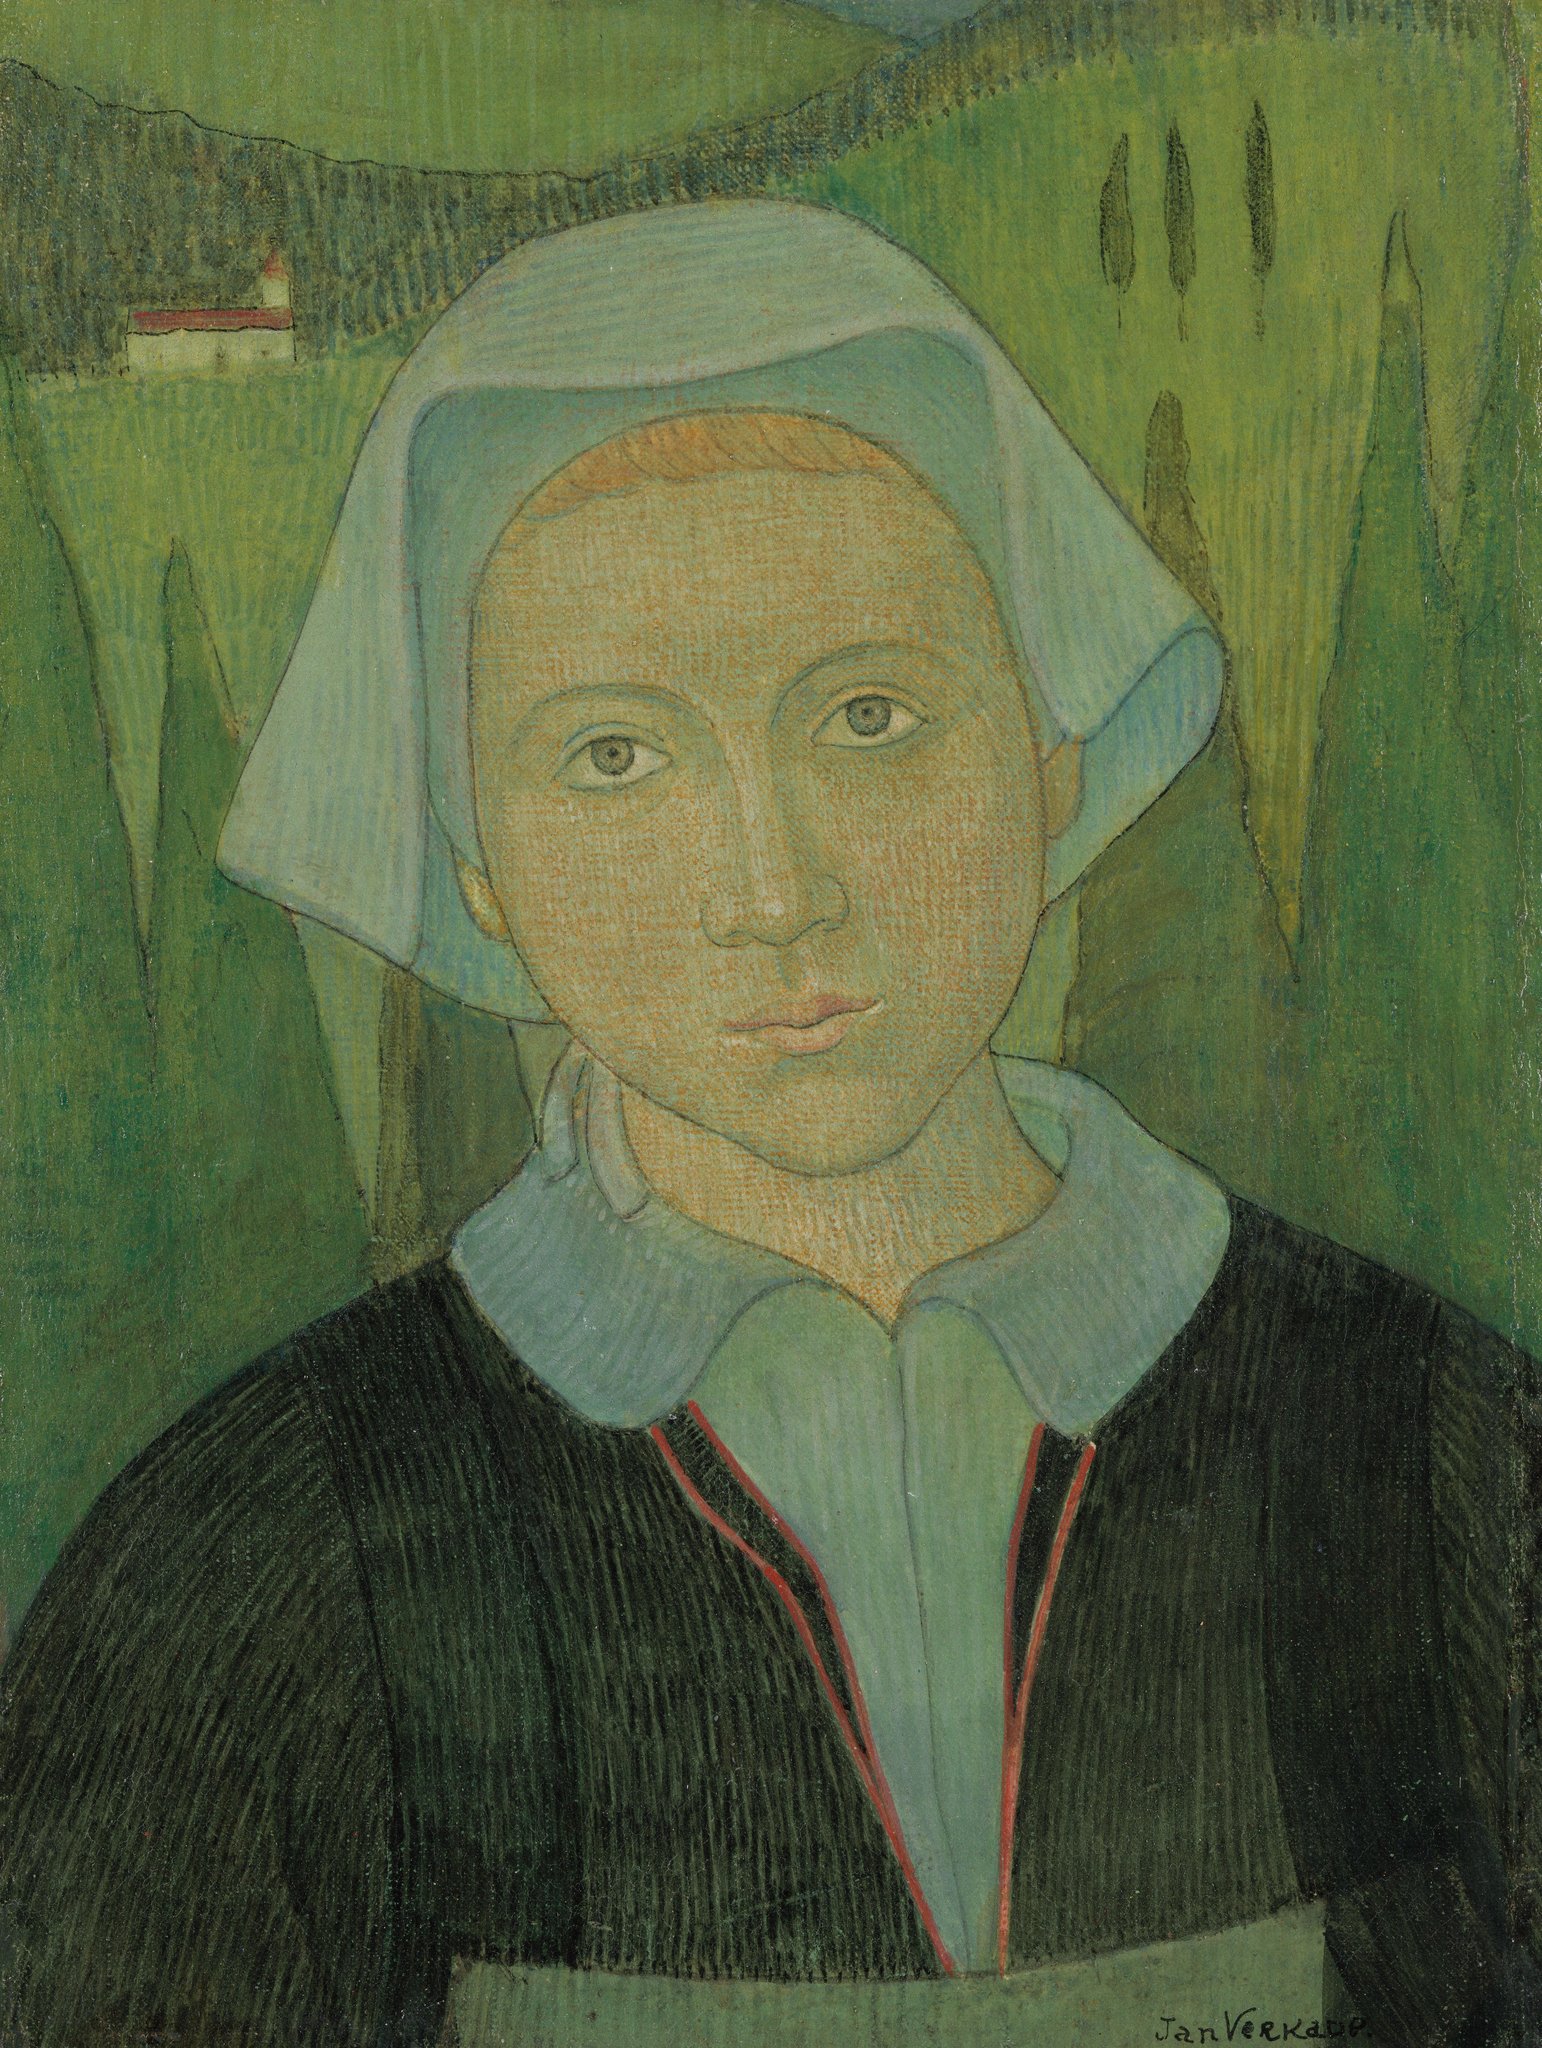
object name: painting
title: Memory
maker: jan verkade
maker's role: designer, draughtsman, painter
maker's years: 1868-1946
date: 1893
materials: linen, oil, paint, panel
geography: fiesole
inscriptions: date: ‘1893’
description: The Zaandam painter Jan Verkade was a member of Les Nabis, a group of French painters around Paul Gauguin in Brittany. They had a marked preference for subjects taken from traditional village life, and worked in a colourful, stylized manner. In 1892 Verkade left for Fiesole in Italy, where he would live for three years. His memories of Brittany and appreciation of 15th-century Italian painting resulted in this charming ‘Breton Madonna.’